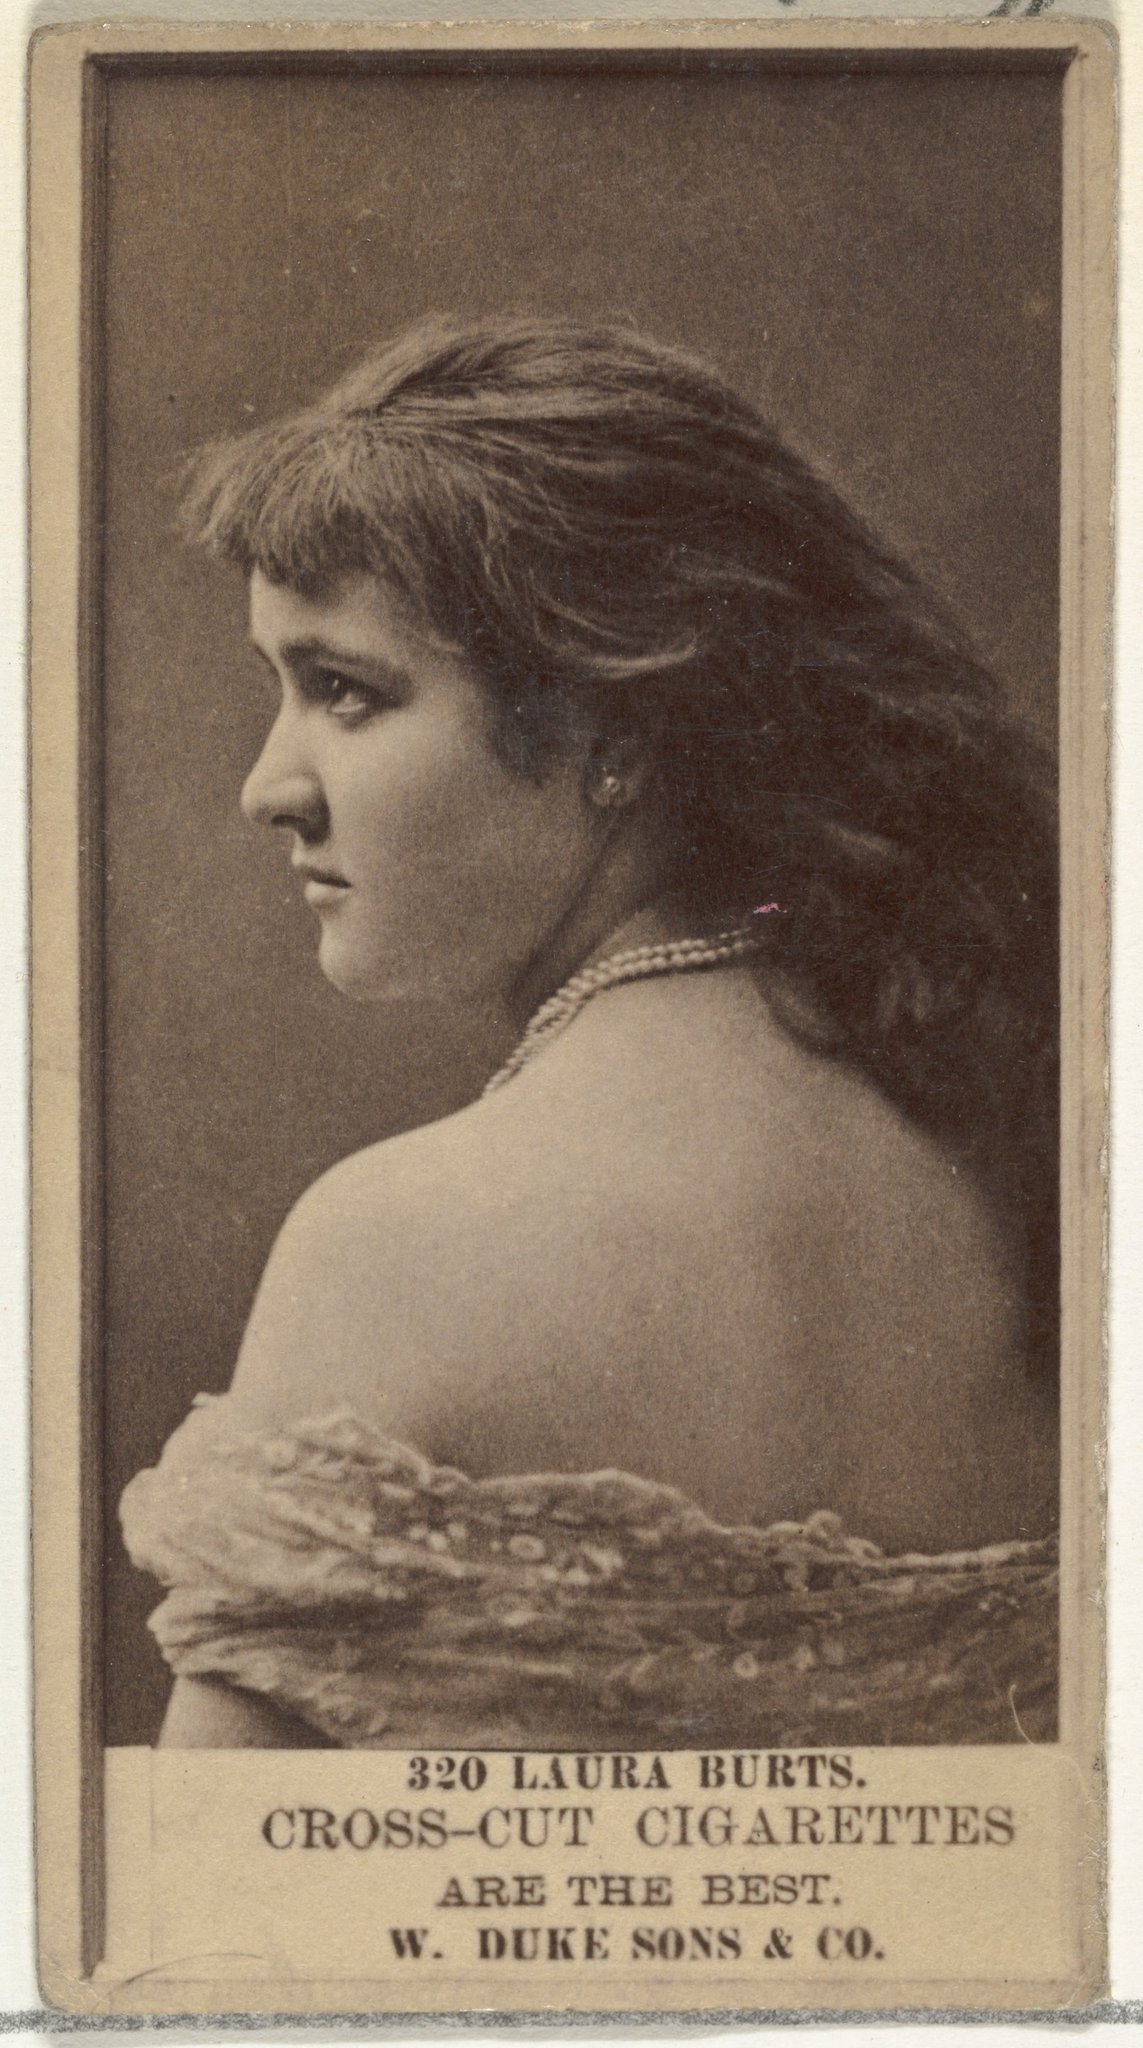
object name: photograph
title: Card Number 320, Laura Burt, from the Actors and Actresses series (N145-3) issued by Duke Sons & Co. to promote Cross Cut Cigarettes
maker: w. duke, sons & co.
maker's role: publisher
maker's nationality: american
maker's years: 1870-1920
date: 1880-1889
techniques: albumen silver print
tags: women,actresses